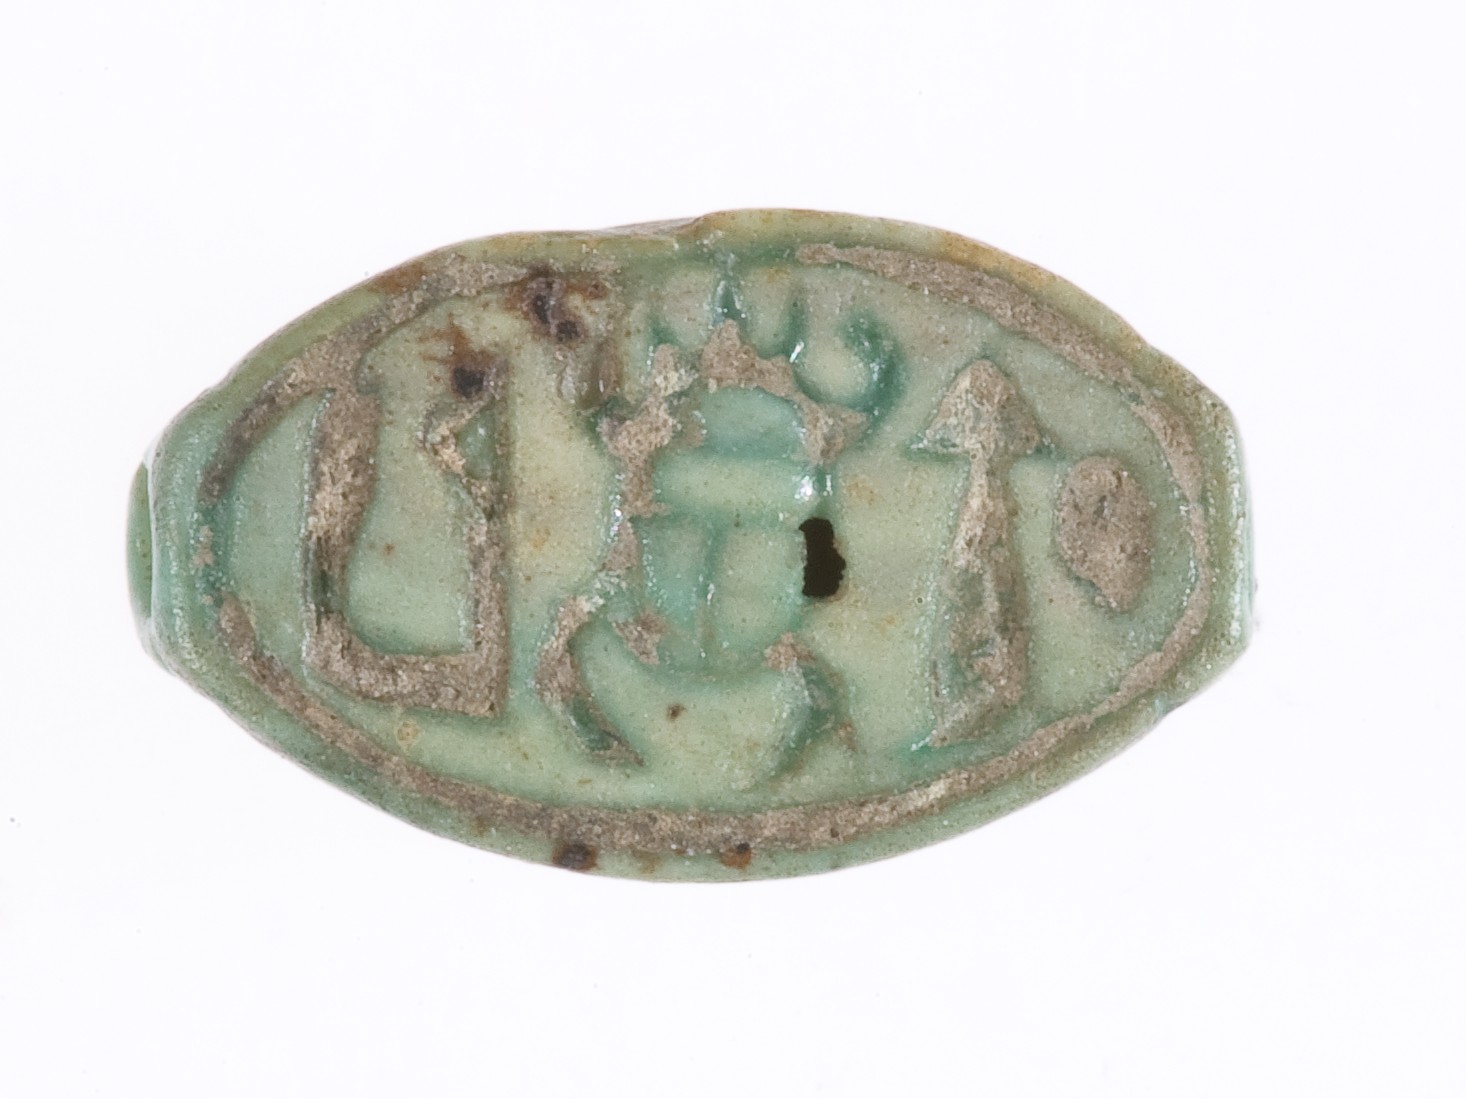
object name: cowroid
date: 1550-1458 BCE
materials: stone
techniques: glazing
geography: egypt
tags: scarabs